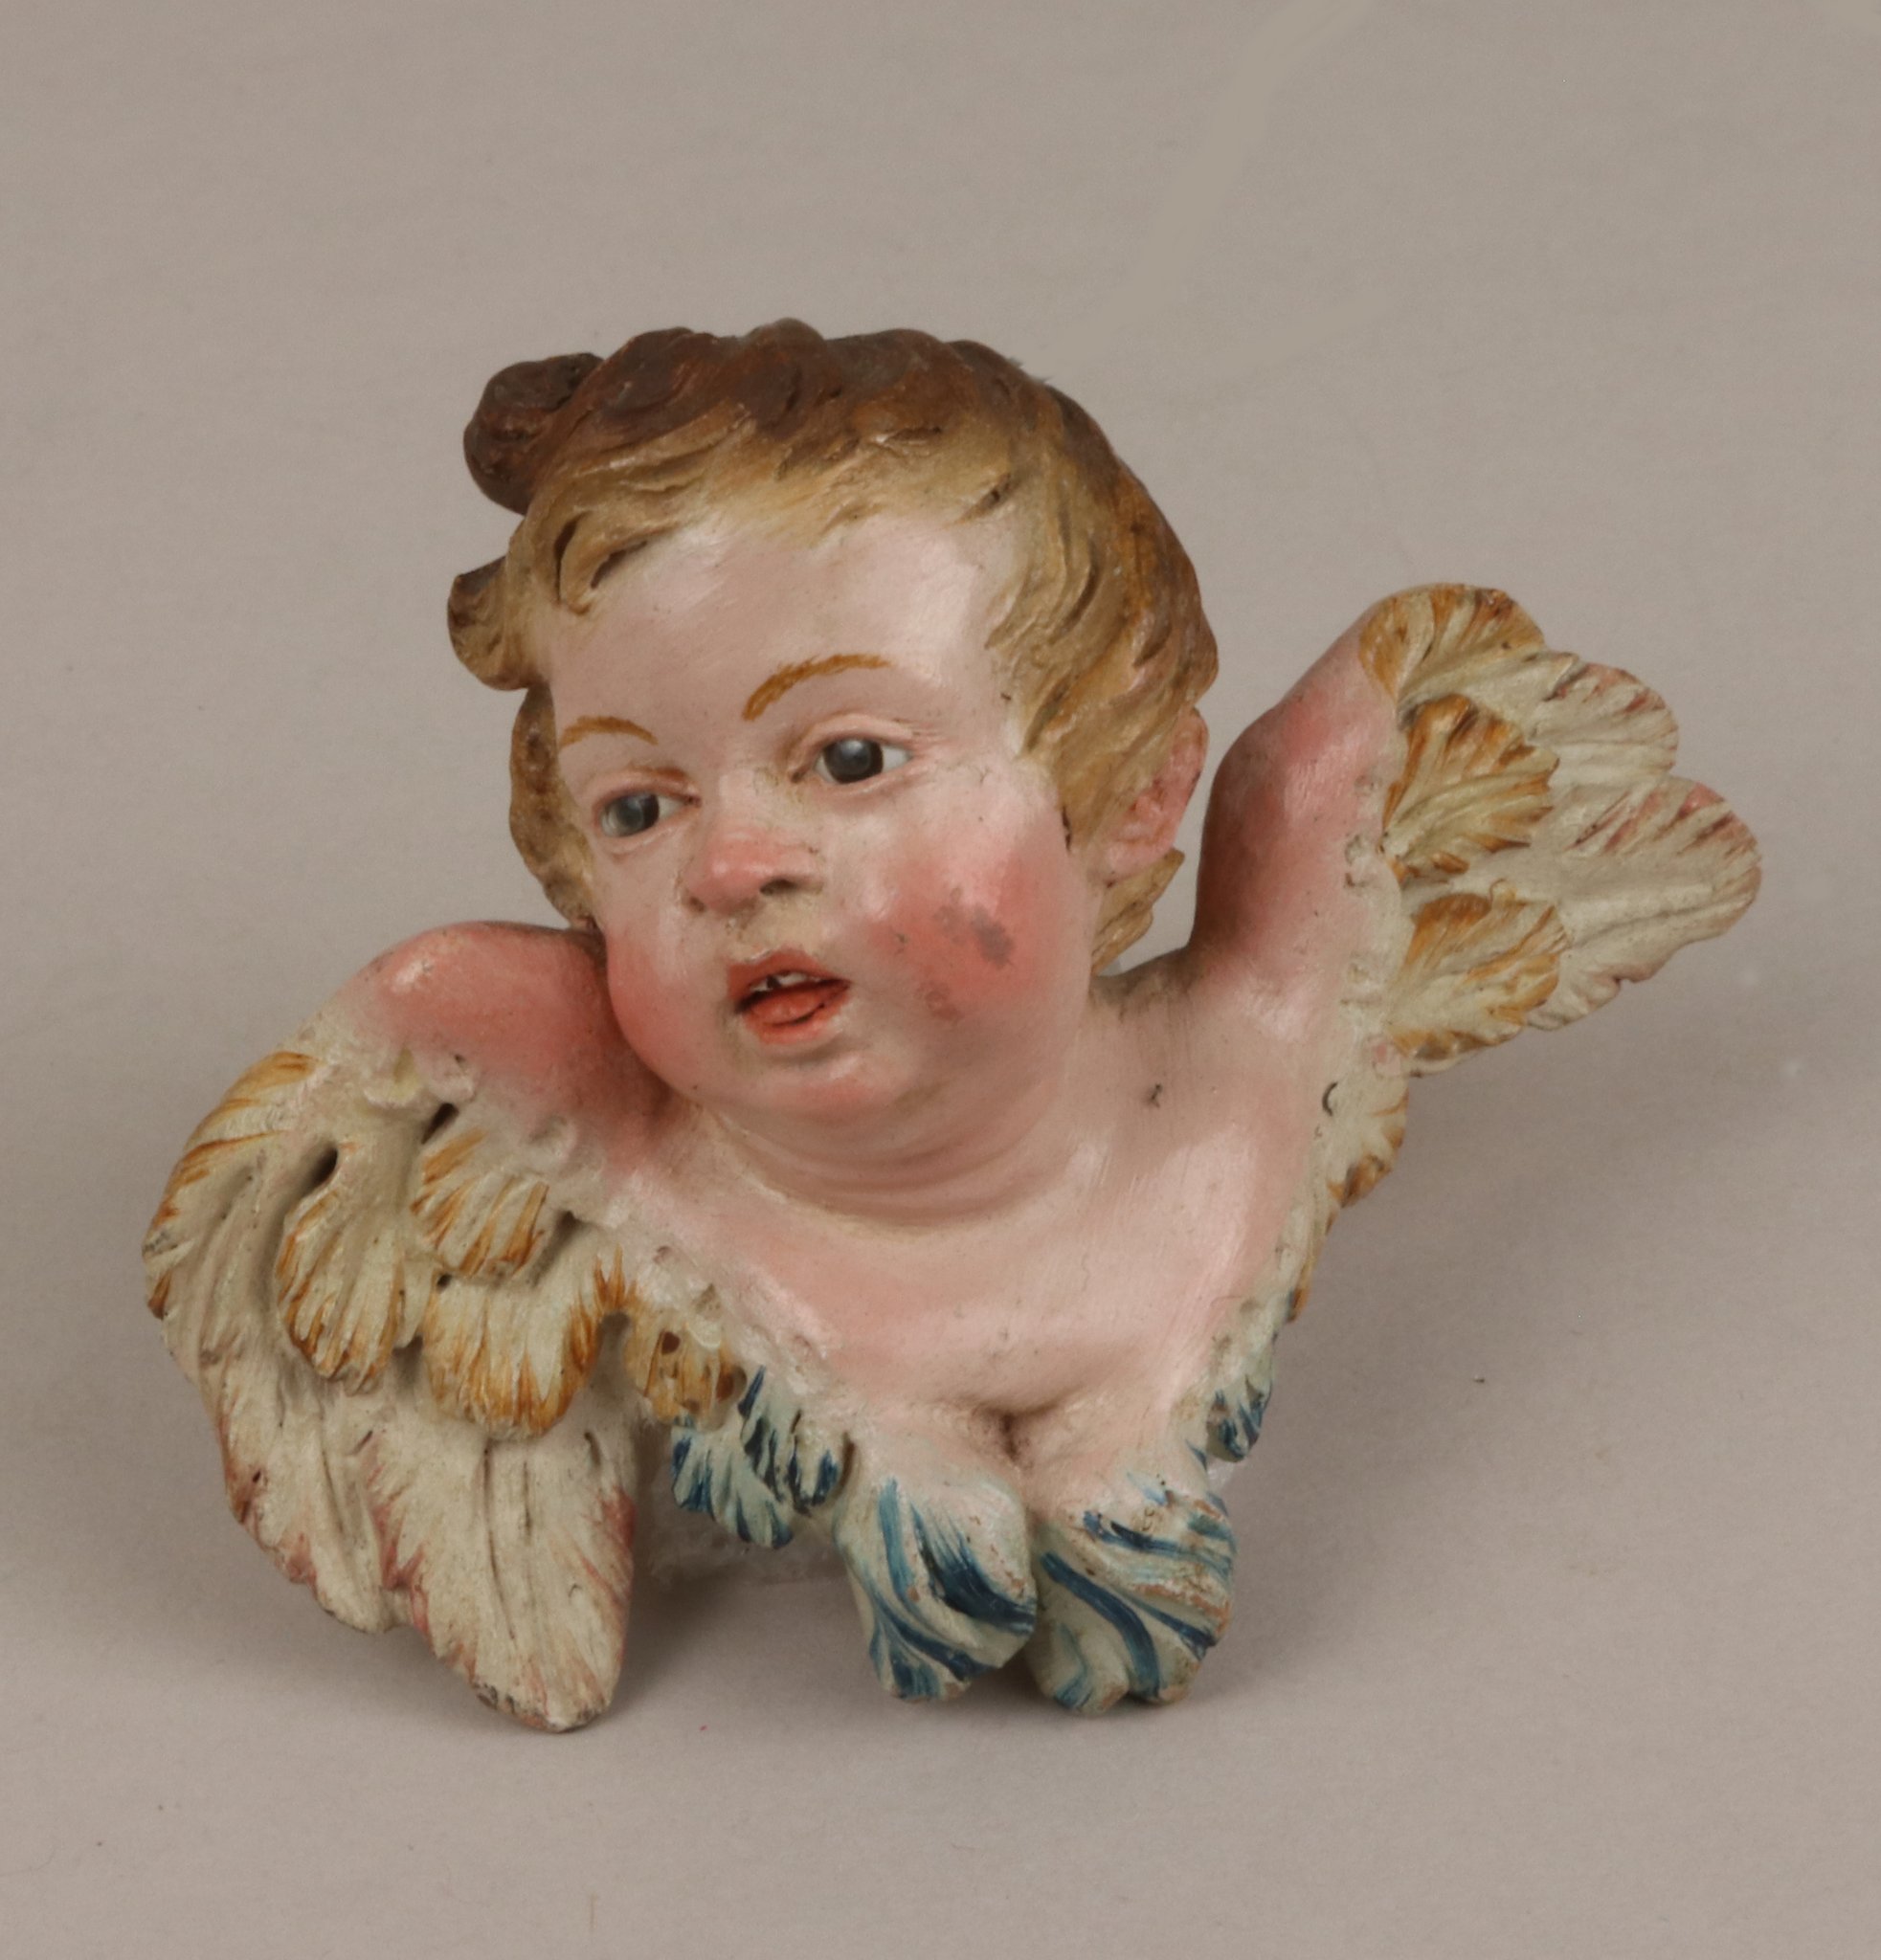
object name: crèche figure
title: Putto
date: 1701-1800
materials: terracotta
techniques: polychrome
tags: putti